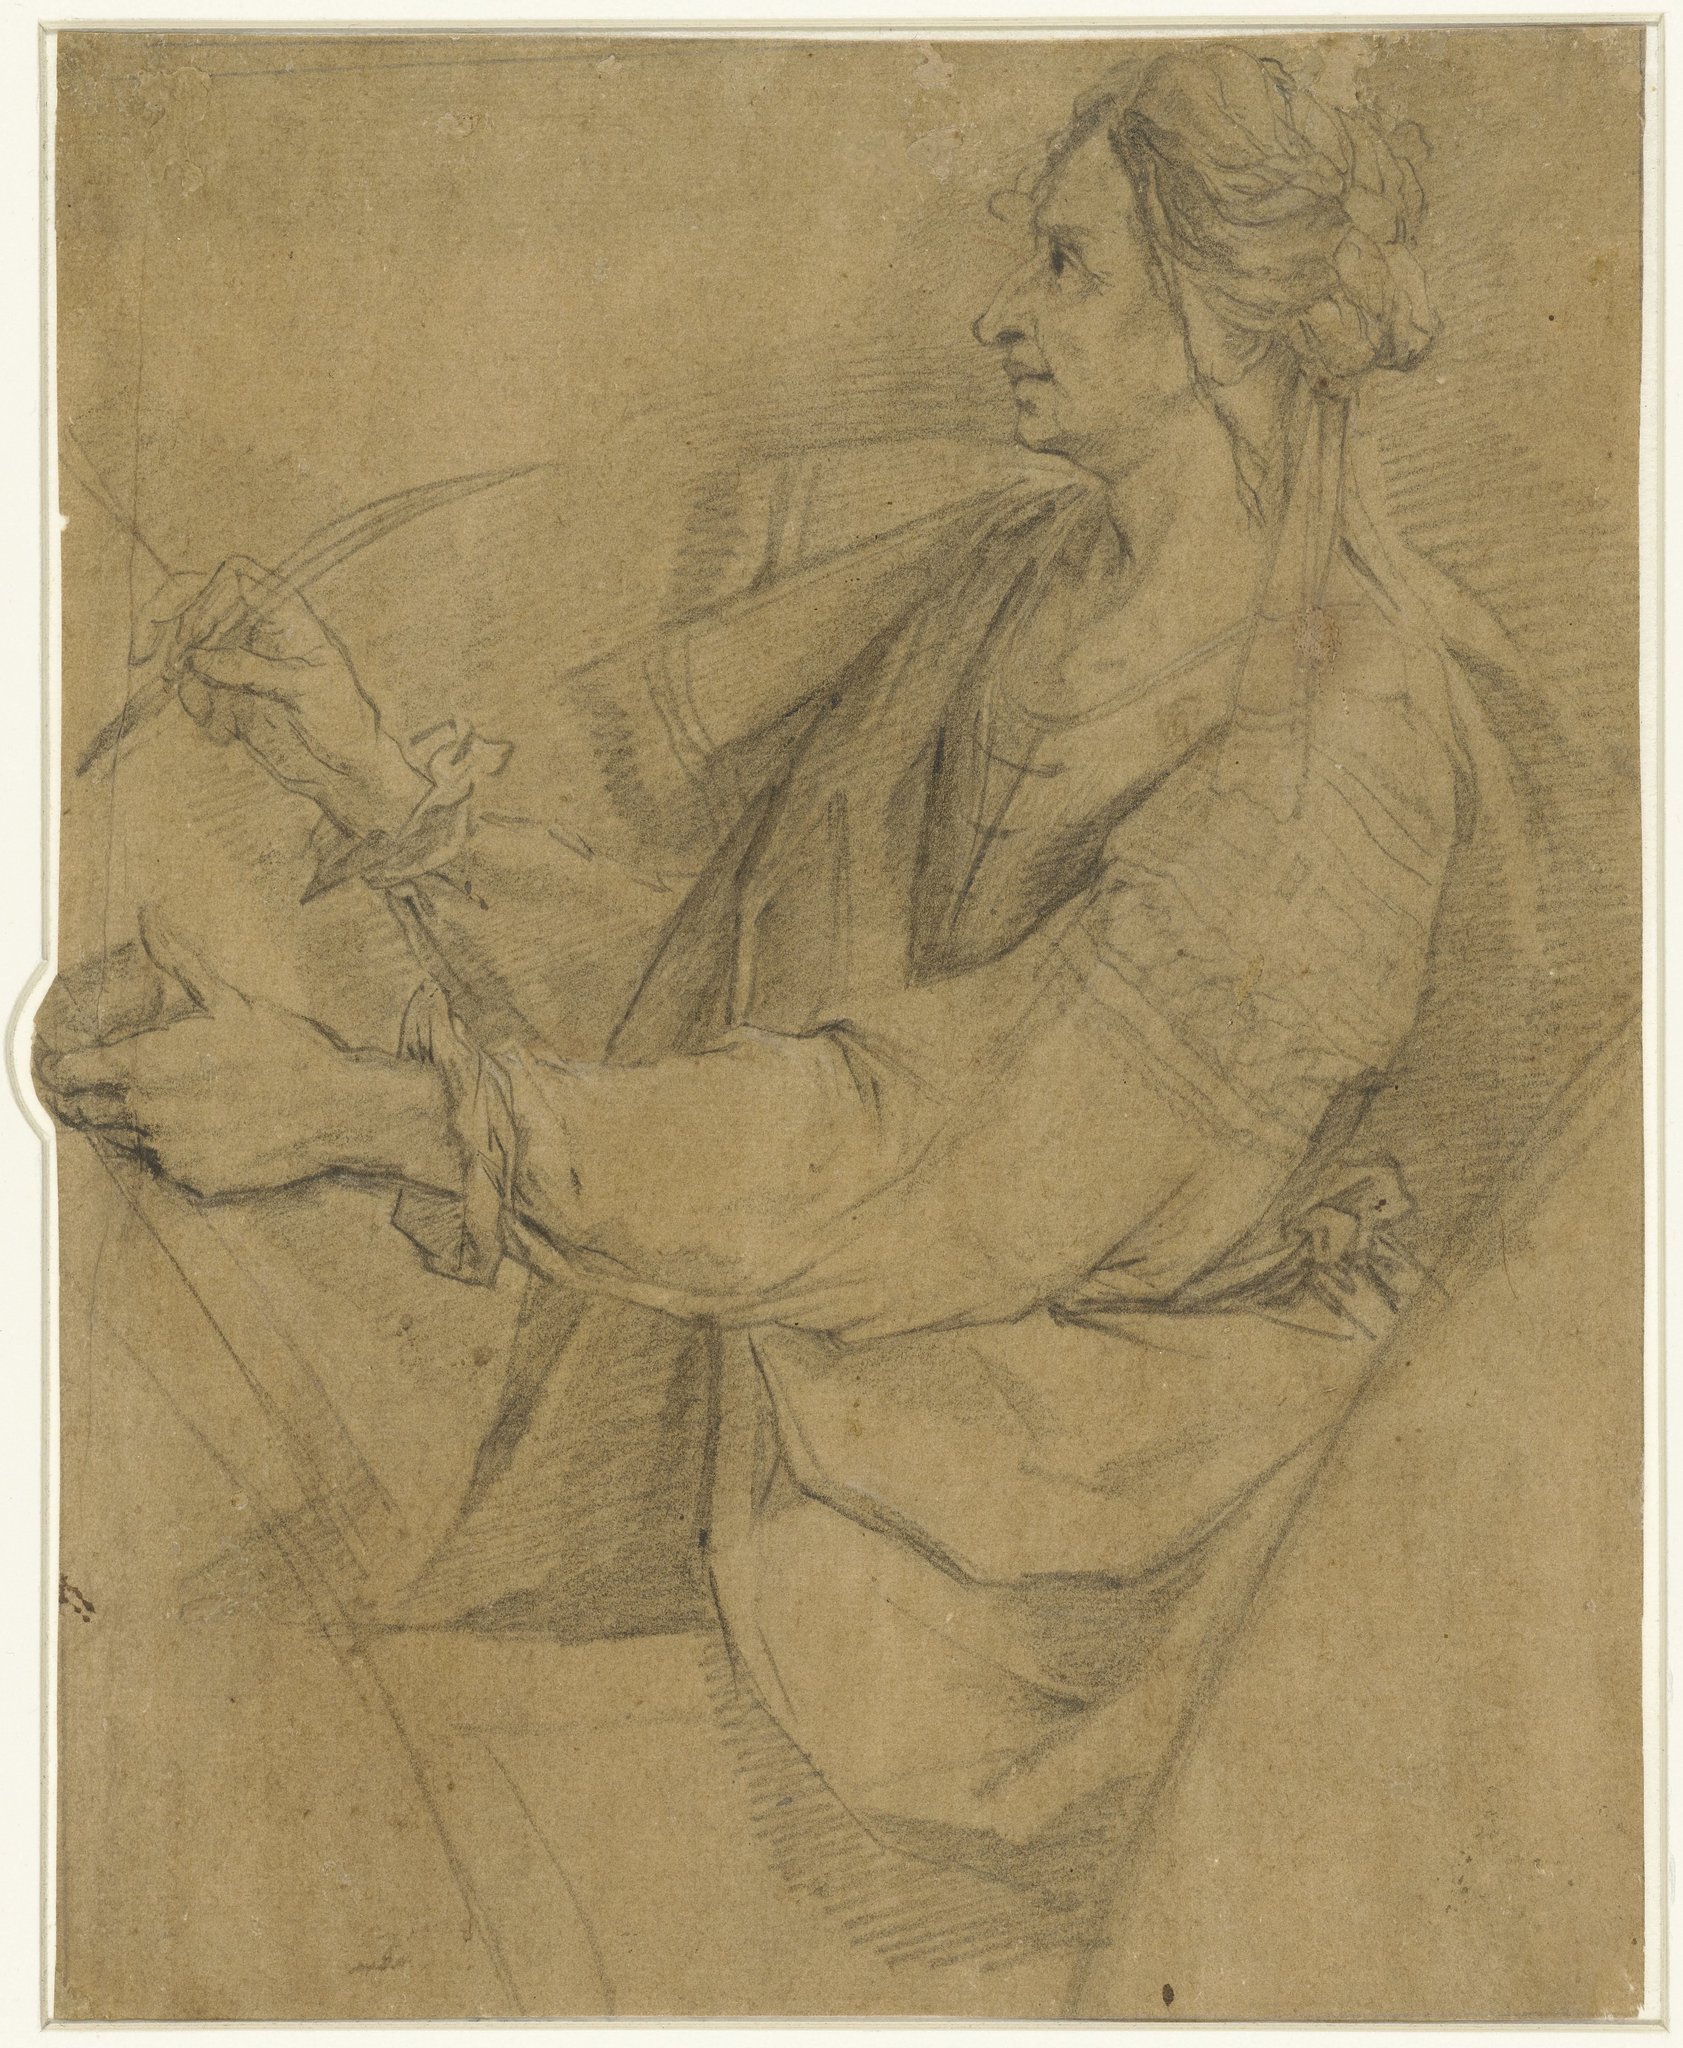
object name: design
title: Sibylle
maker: ventura salimbeni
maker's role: draughtsman, painter, print maker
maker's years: 1568-1613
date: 1567-1613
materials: chalk, paper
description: Ontwerp voor een zwikvulling voor een fresco.